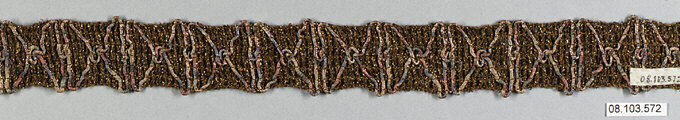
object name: galloon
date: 1701-1800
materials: metal thread